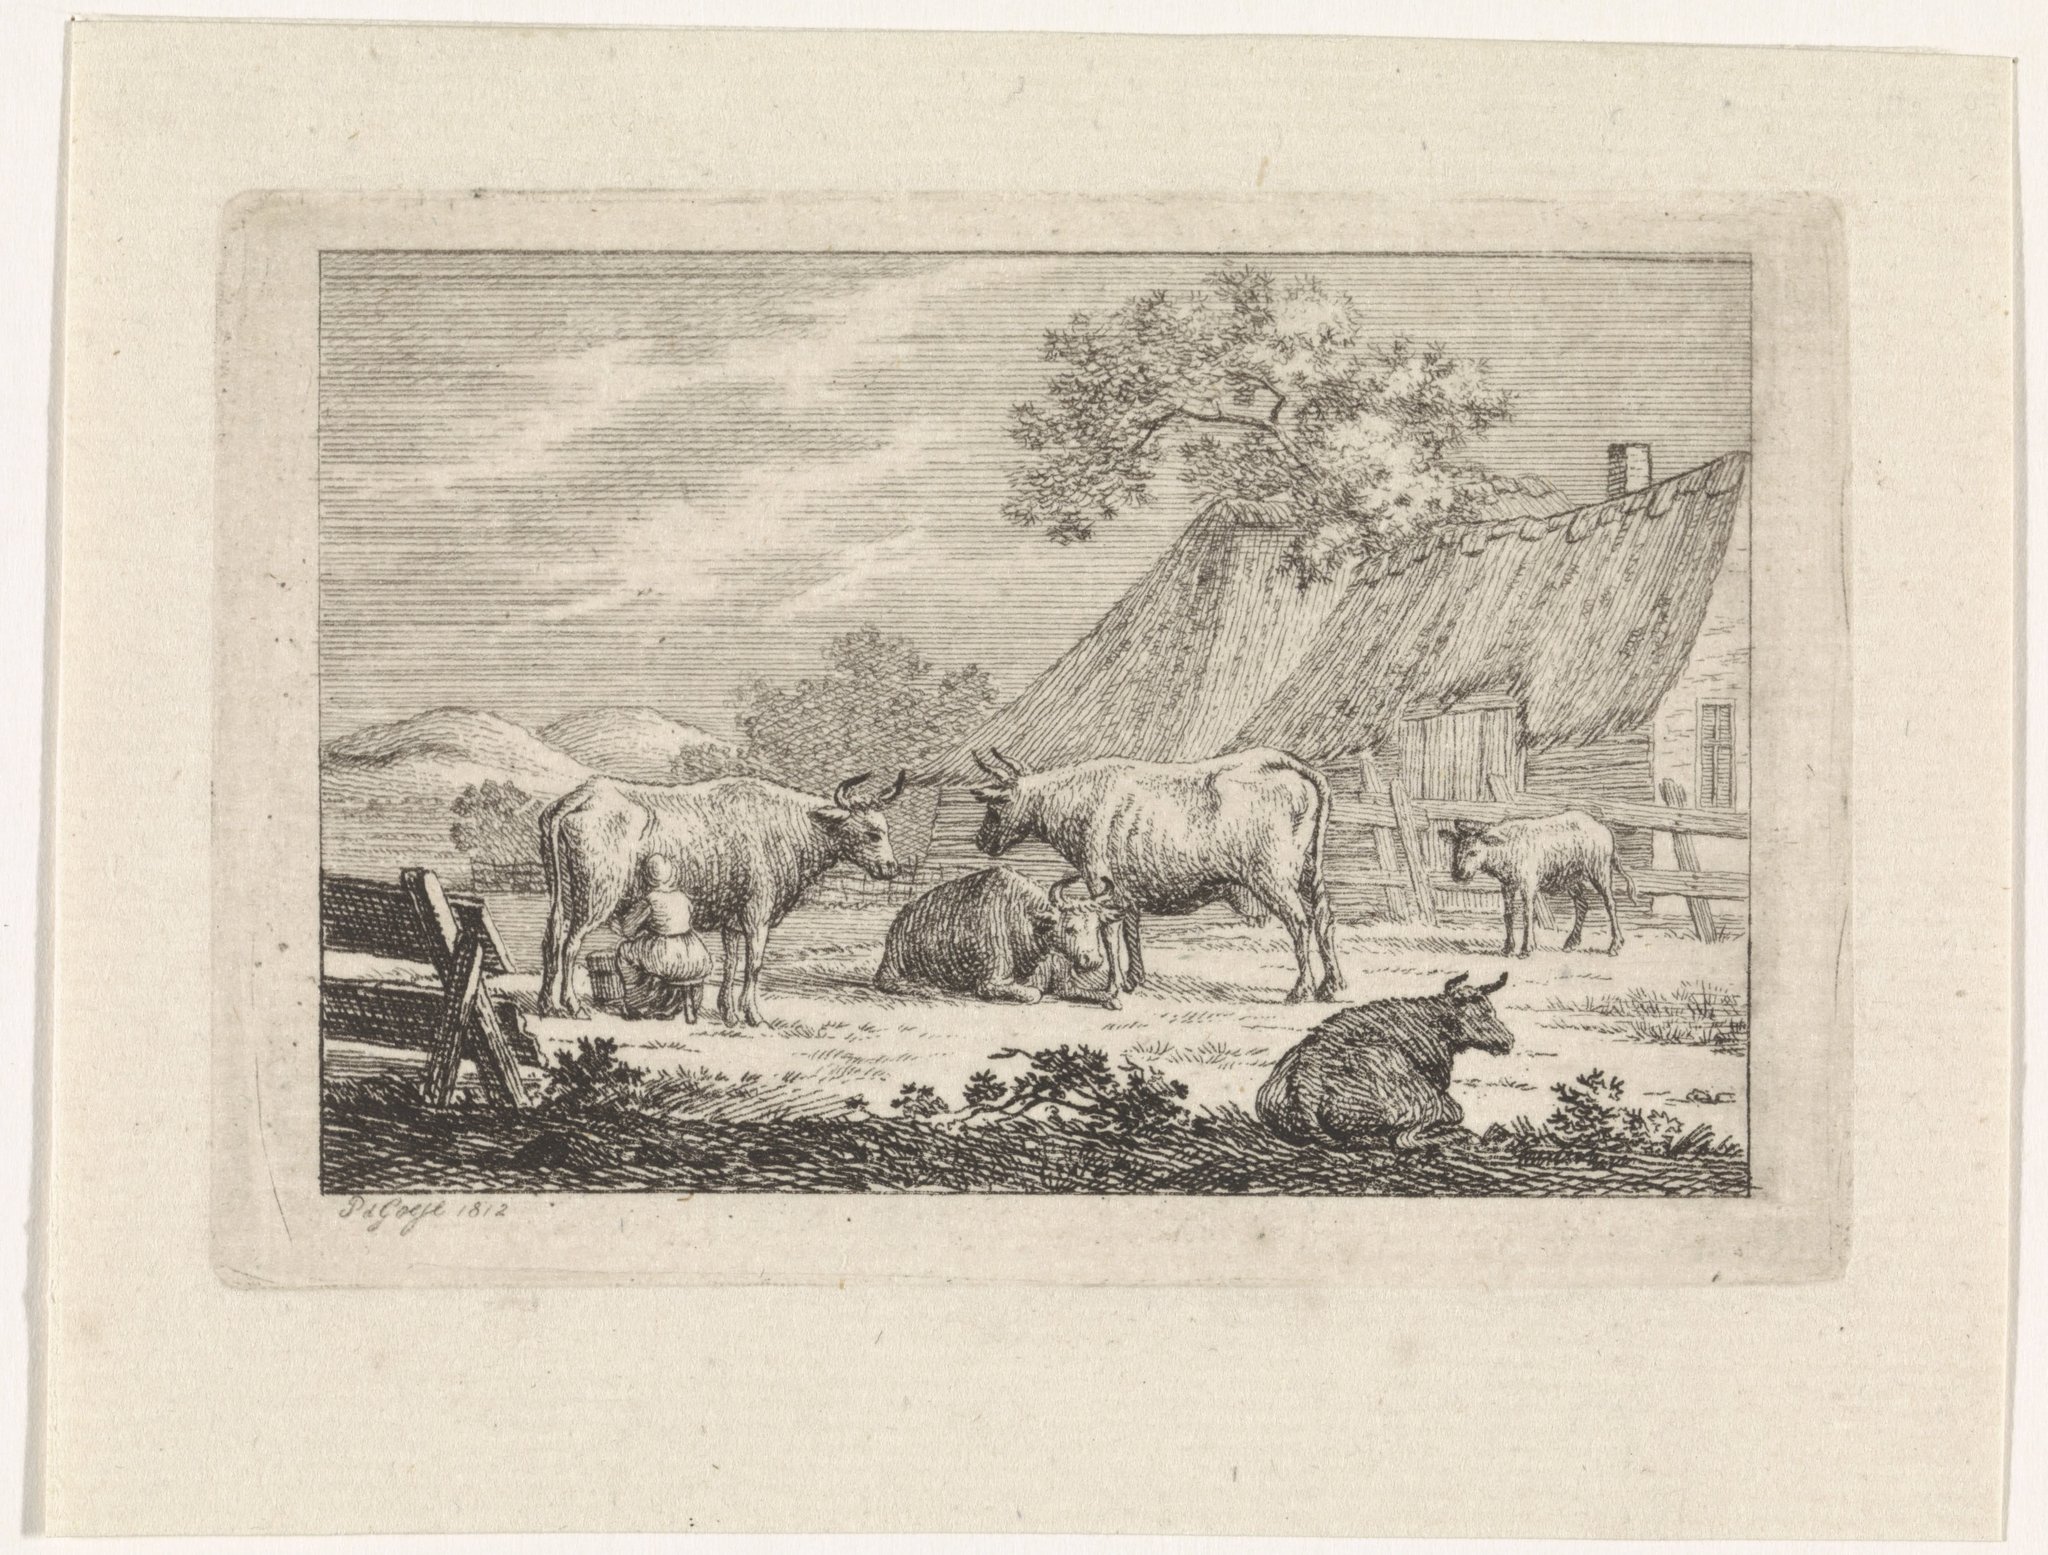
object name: print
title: Boerenerf met koeien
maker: pieter de goeje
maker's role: draughtsman, print maker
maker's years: 1789-1859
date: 1812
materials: paper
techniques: etching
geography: amsterdam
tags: cow, farmers - aa - female farmer, farmer's wife, farm (building), milking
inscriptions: collector's mark: Lugt 2228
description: Een weide met vier koeien en een kalf. Een van de koeien wordt door een boerin gemolken. Op de achtergrond de boerderij.